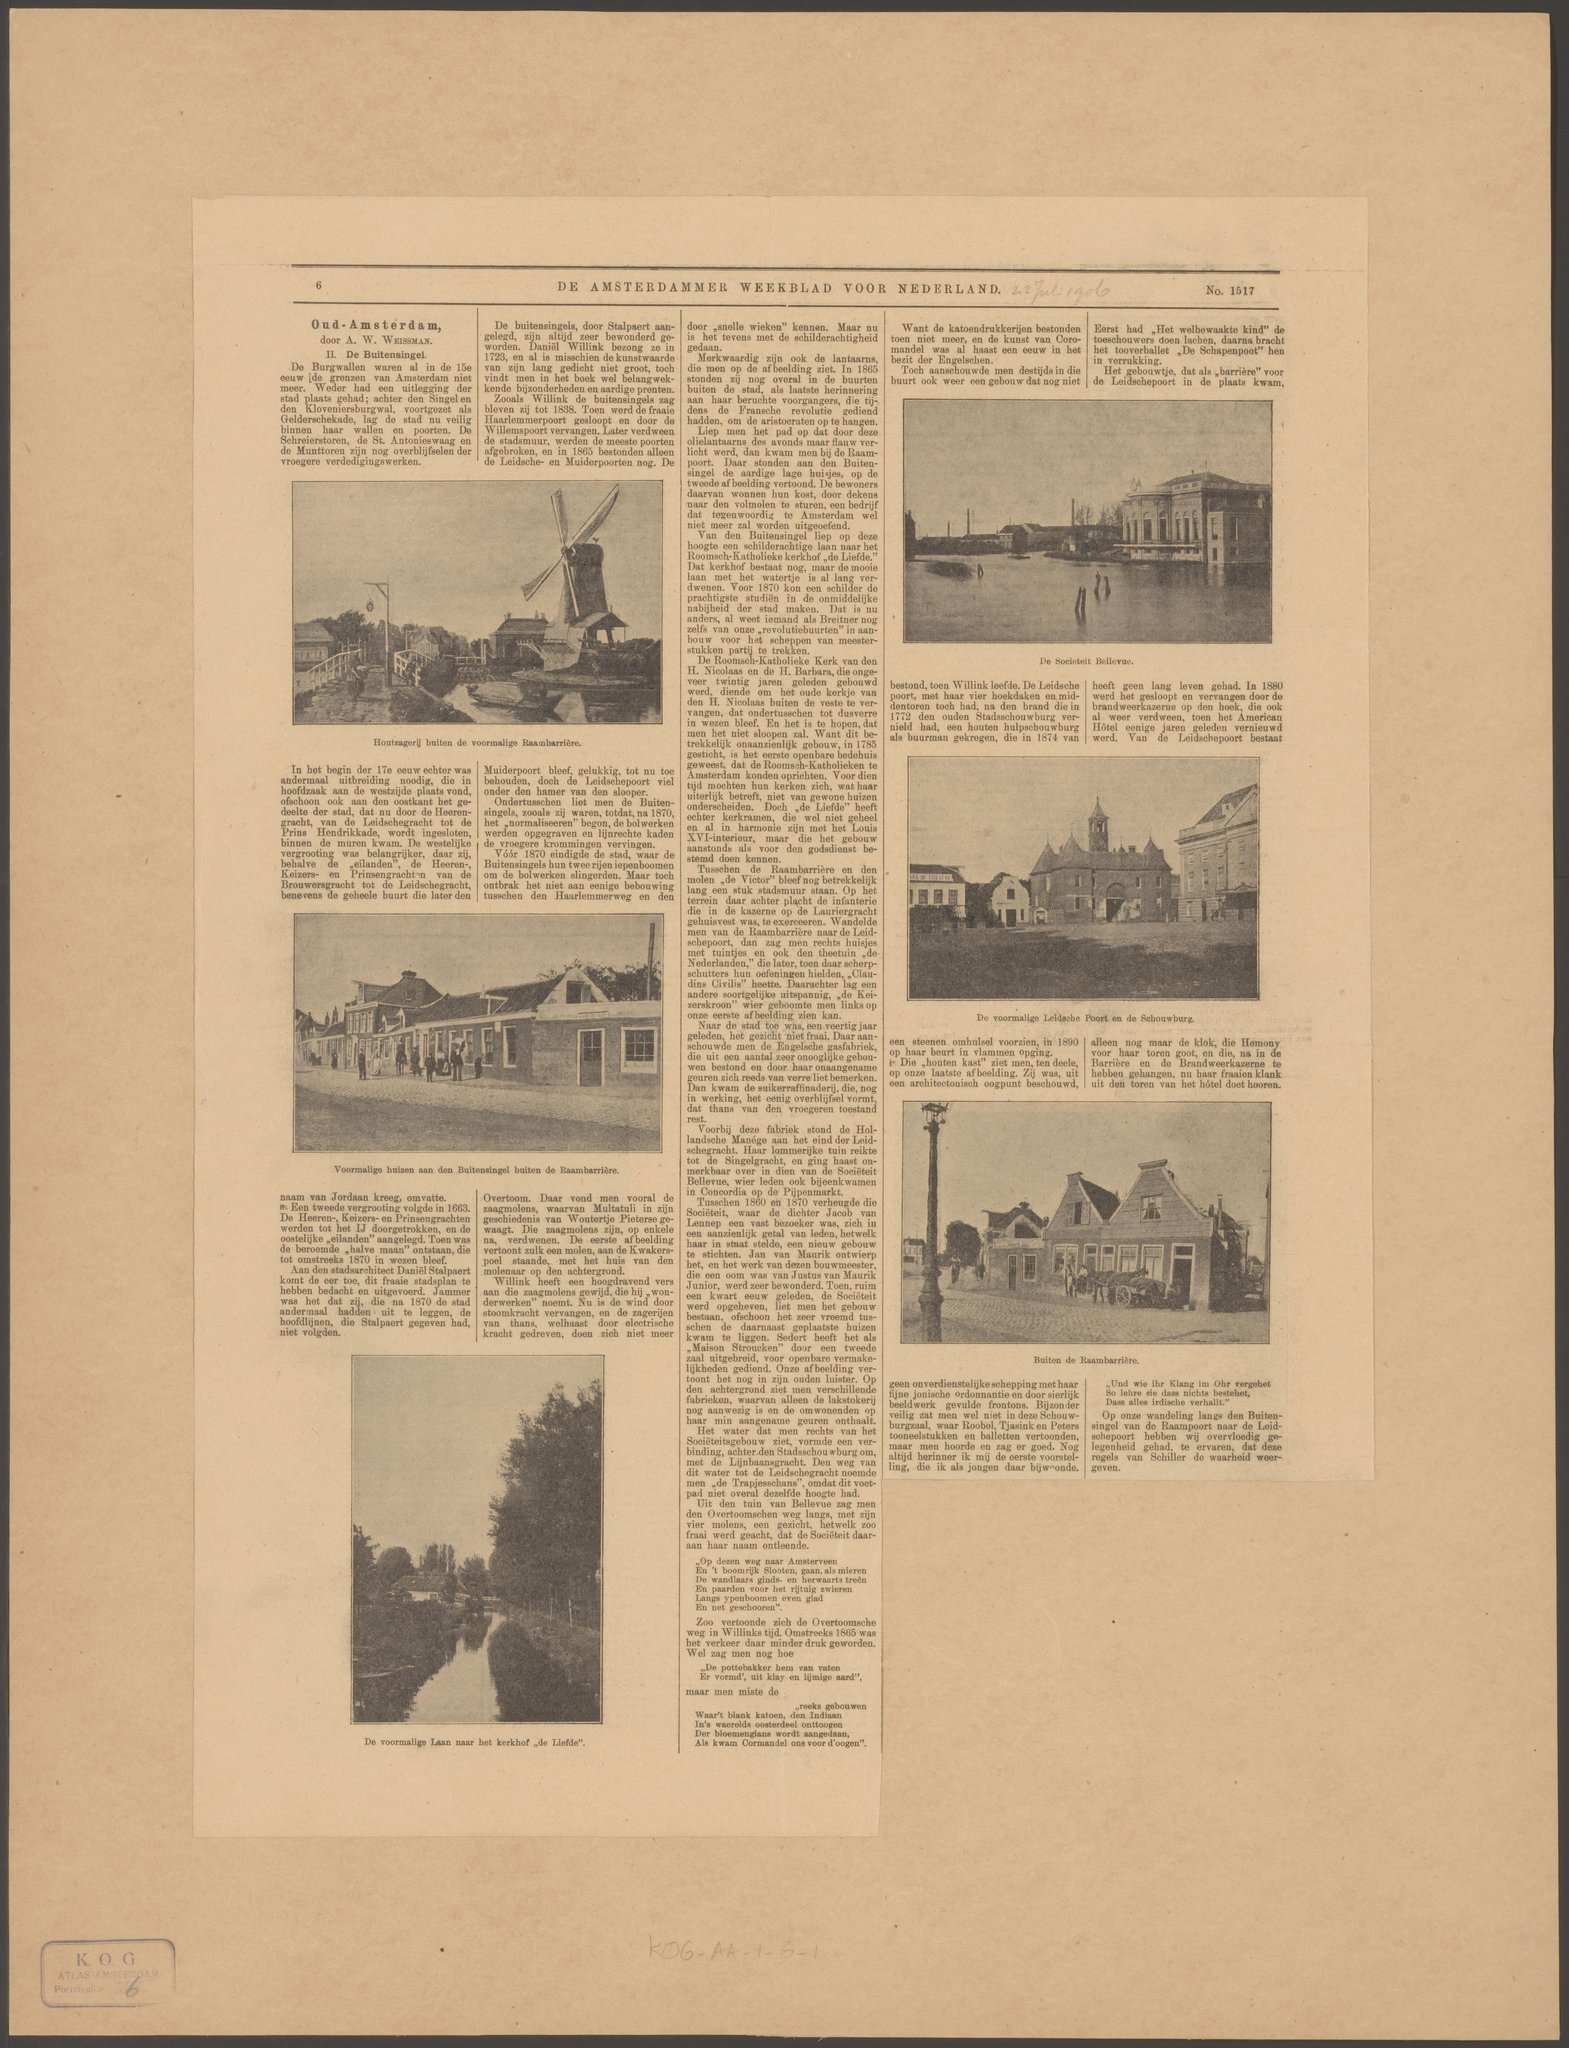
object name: photomechanical print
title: Krantenknipsel over enkele verdwenen gebieden en gebouwen in Amsterdam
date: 1906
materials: paper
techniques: letterpress printing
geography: amsterdam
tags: city-view in general; 'veduta', canal, windmill in landscape, city-gate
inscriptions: collector's mark: ‘6’ Lugt 1641b, date: ‘22 Juli 1906’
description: Onderwerpsrubriek binnen de Atlas Amsterdam: Buitensingel of wel: Gezichten langs en op de Stadsvest van Haarlemmerpoort tot Raampoort.